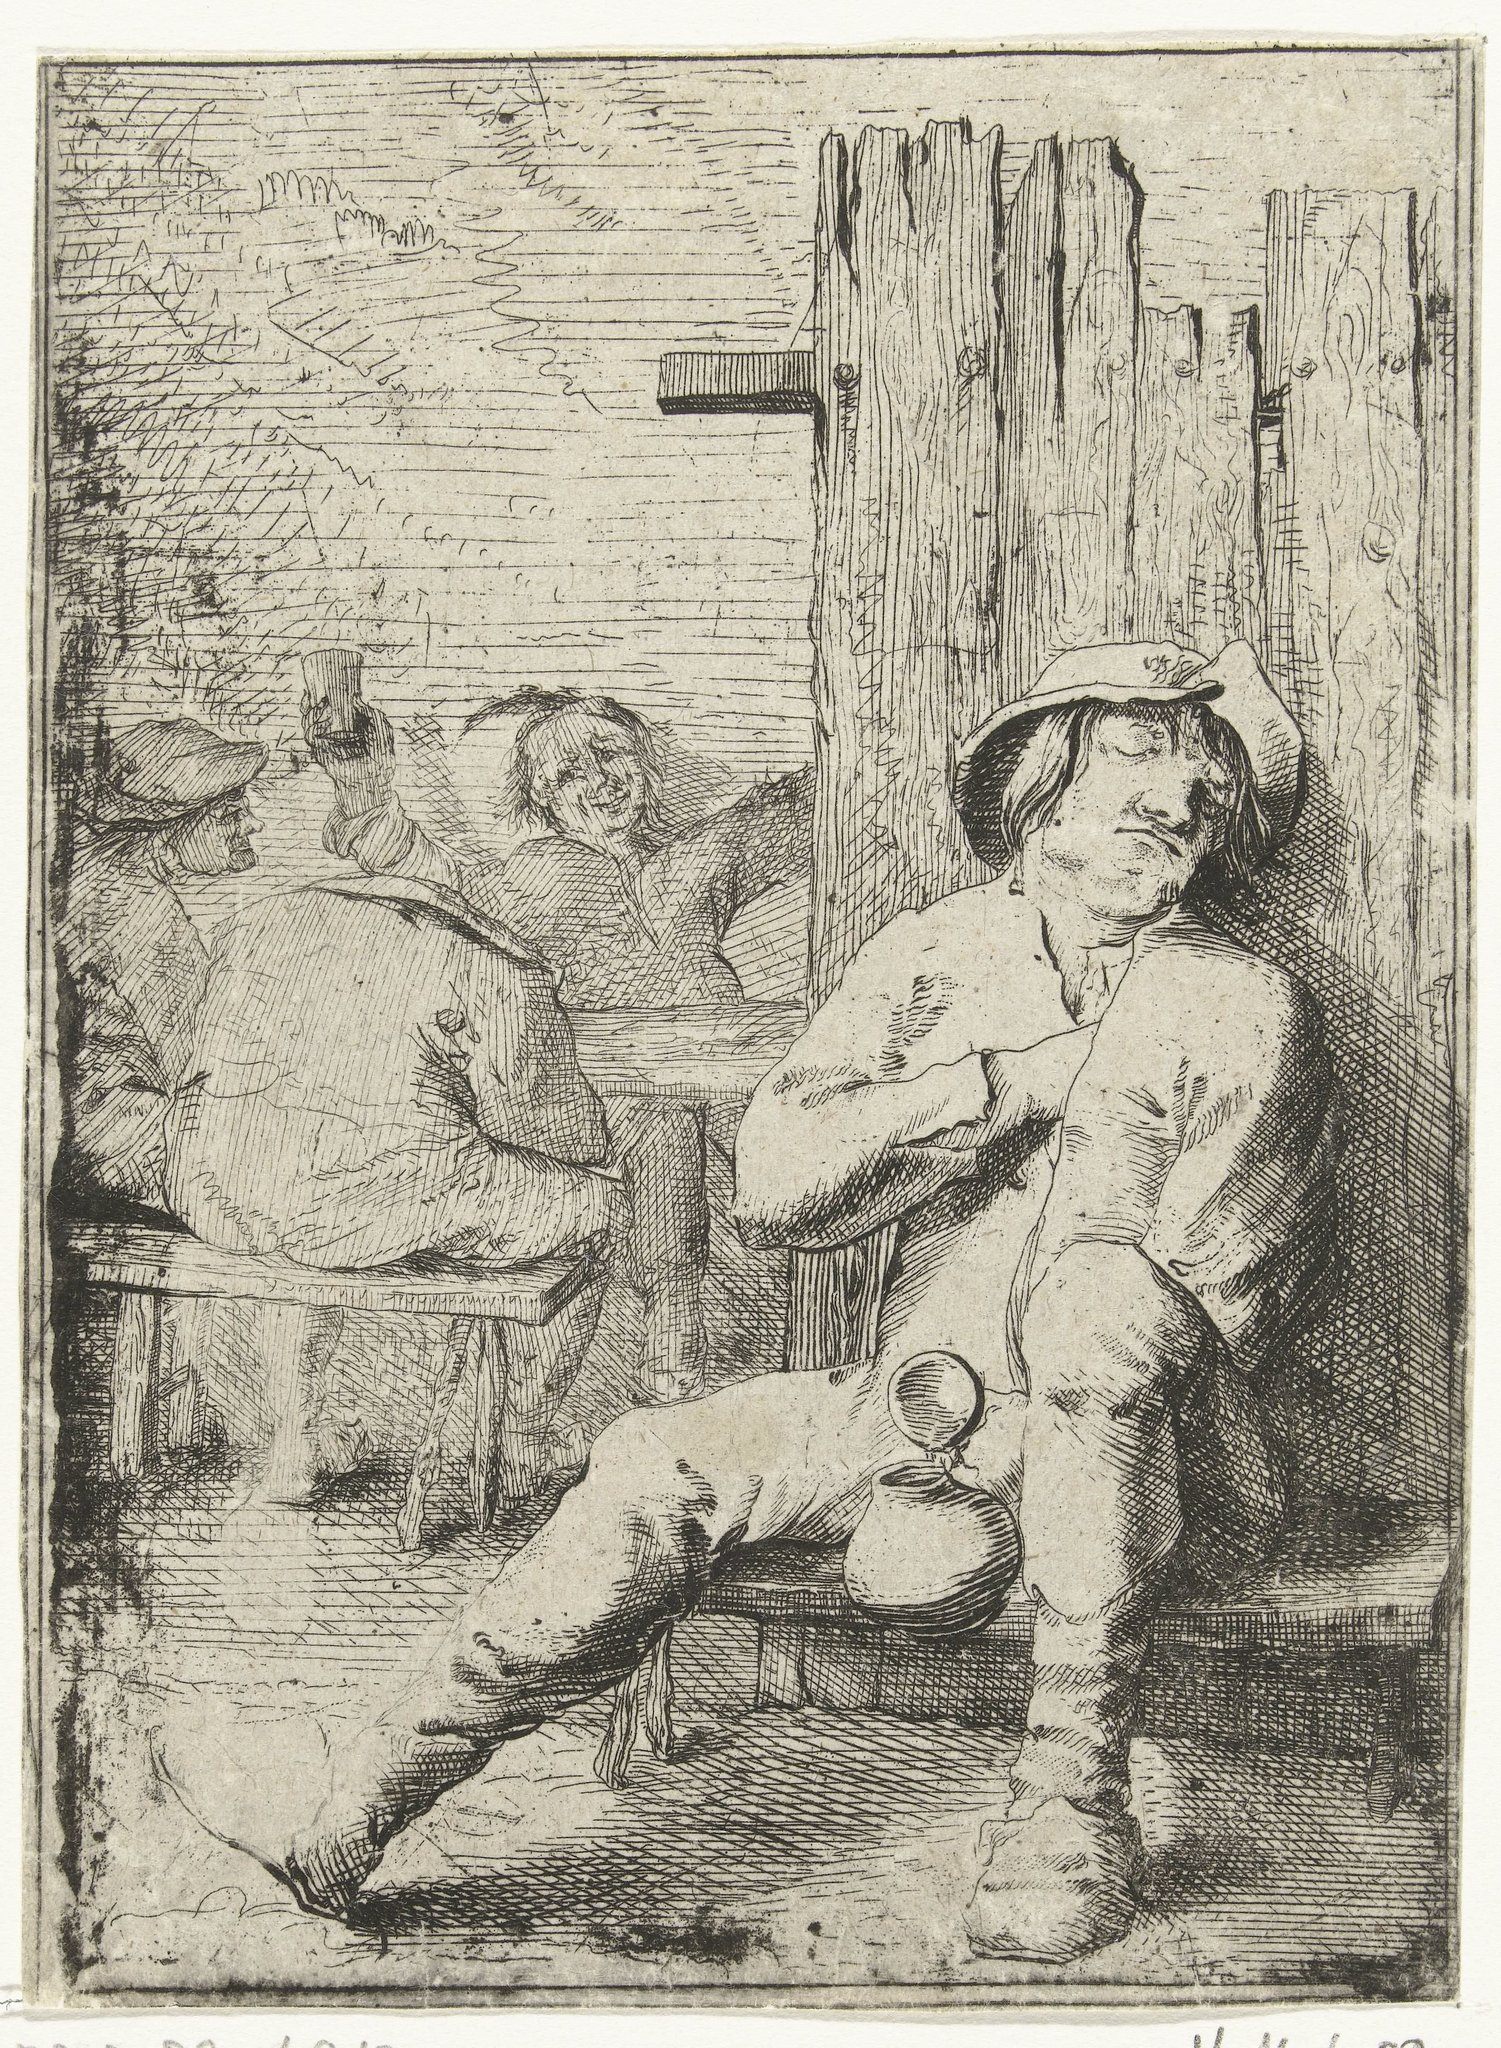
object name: print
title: Slapende boer, zittend op een bank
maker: Anonymous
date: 1620-1688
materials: paper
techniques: engraving, etching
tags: sleeping; unconsciousness - bb - out of doors, drunkard, inn, coffee-house, public house, etc.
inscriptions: collector's mark: Lugt 240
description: Een slapende boer zit op een lage bank en leunt tegen een hek. Hij houdt een bierkruik in zijn hand. Op de achtergrond zijn drie drinkende boeren aan een tafel te zien.